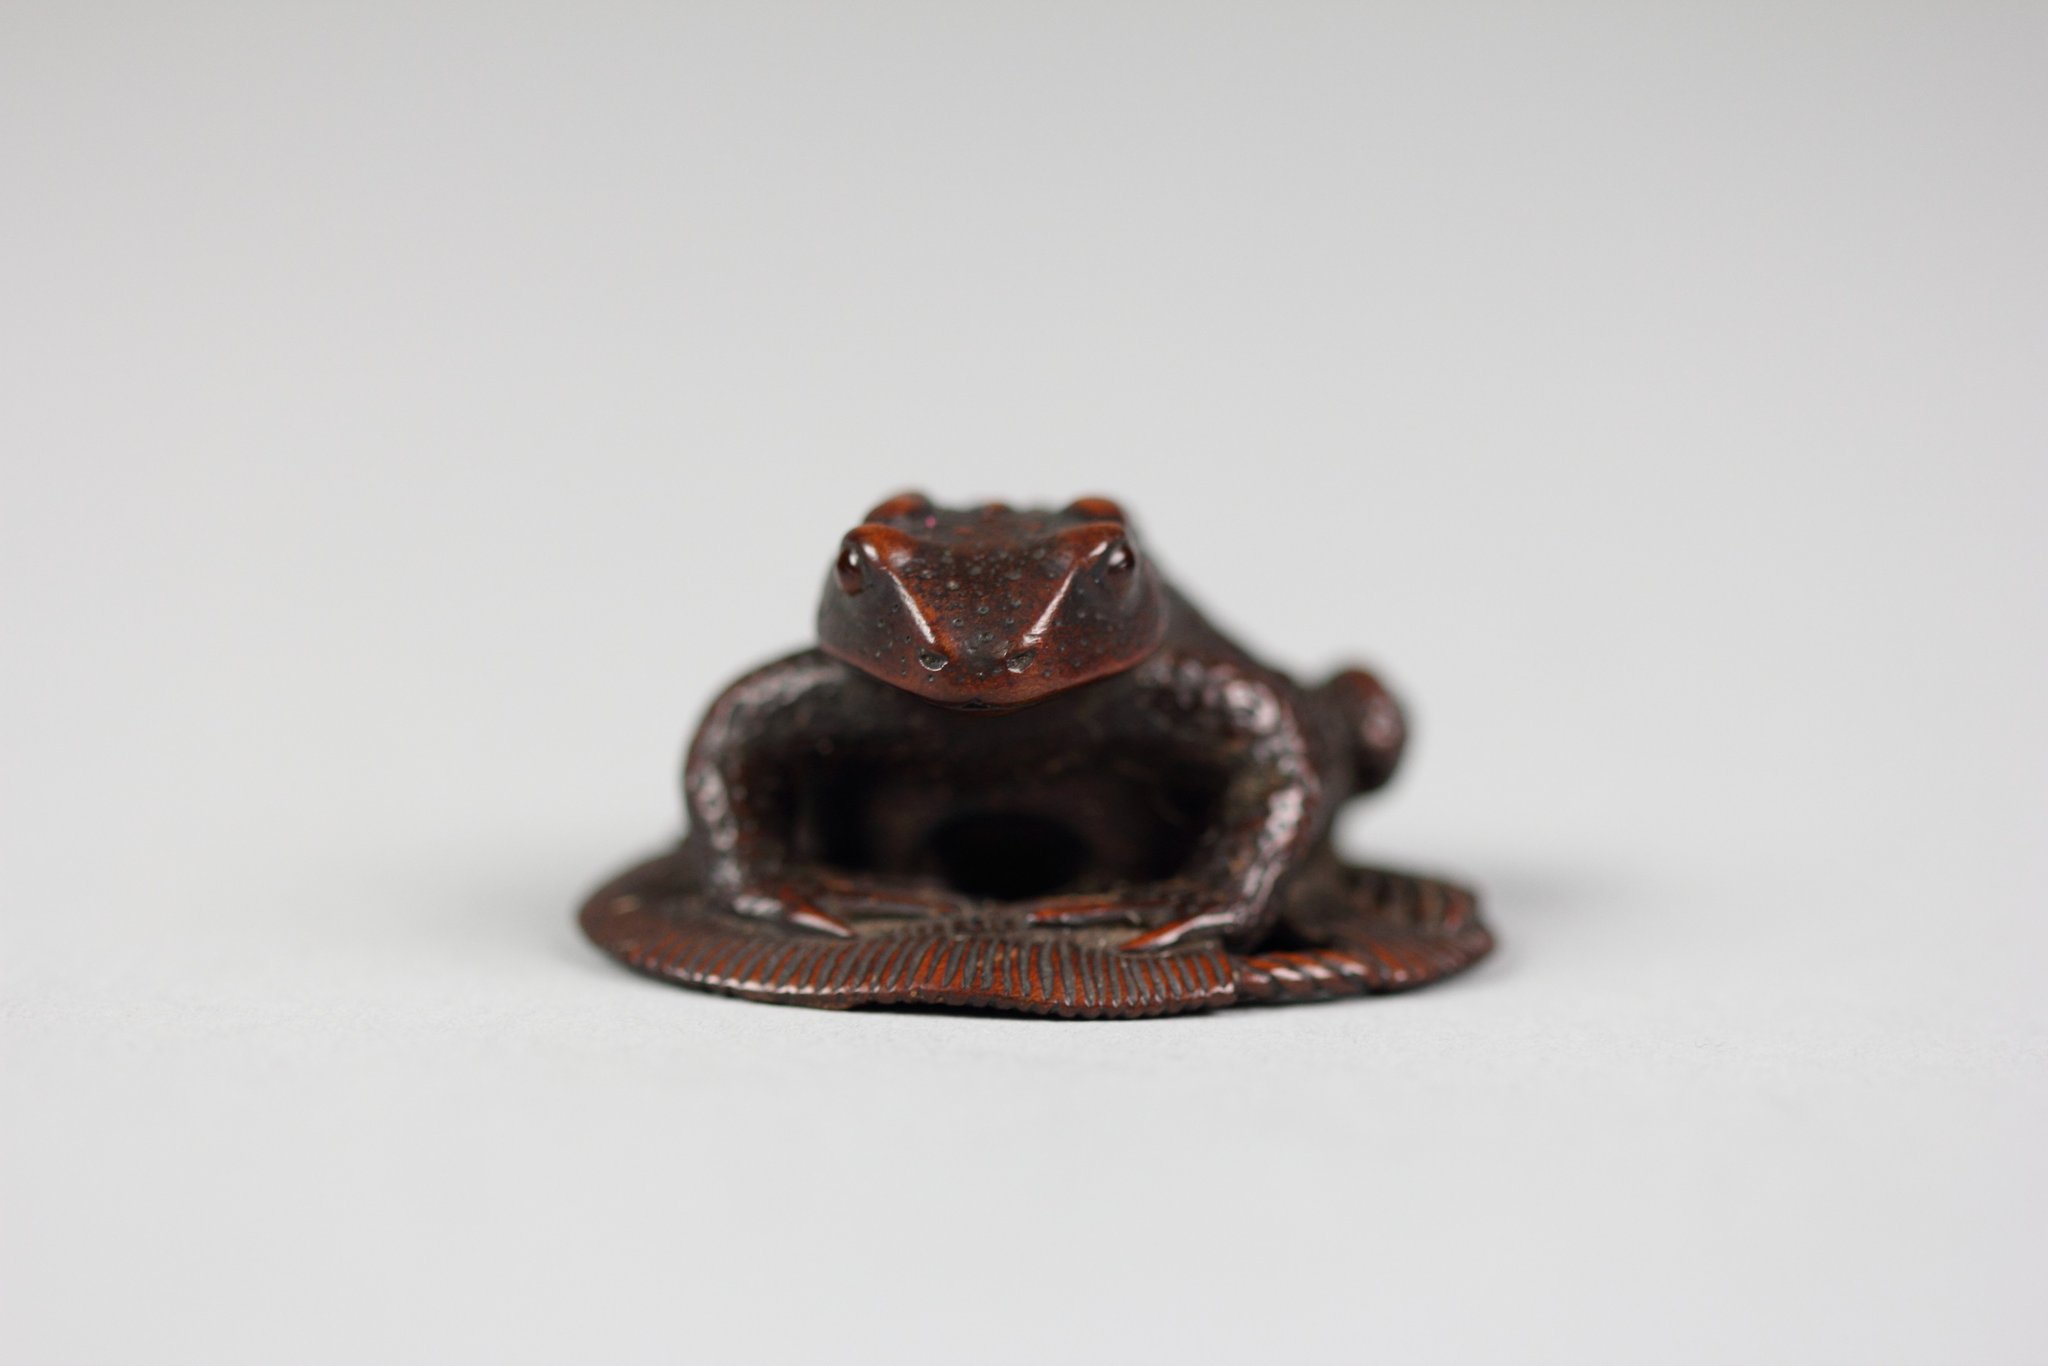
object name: netsuke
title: Netsuke of Toad on a Sandal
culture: japanese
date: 1701-1800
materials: wood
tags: frogs